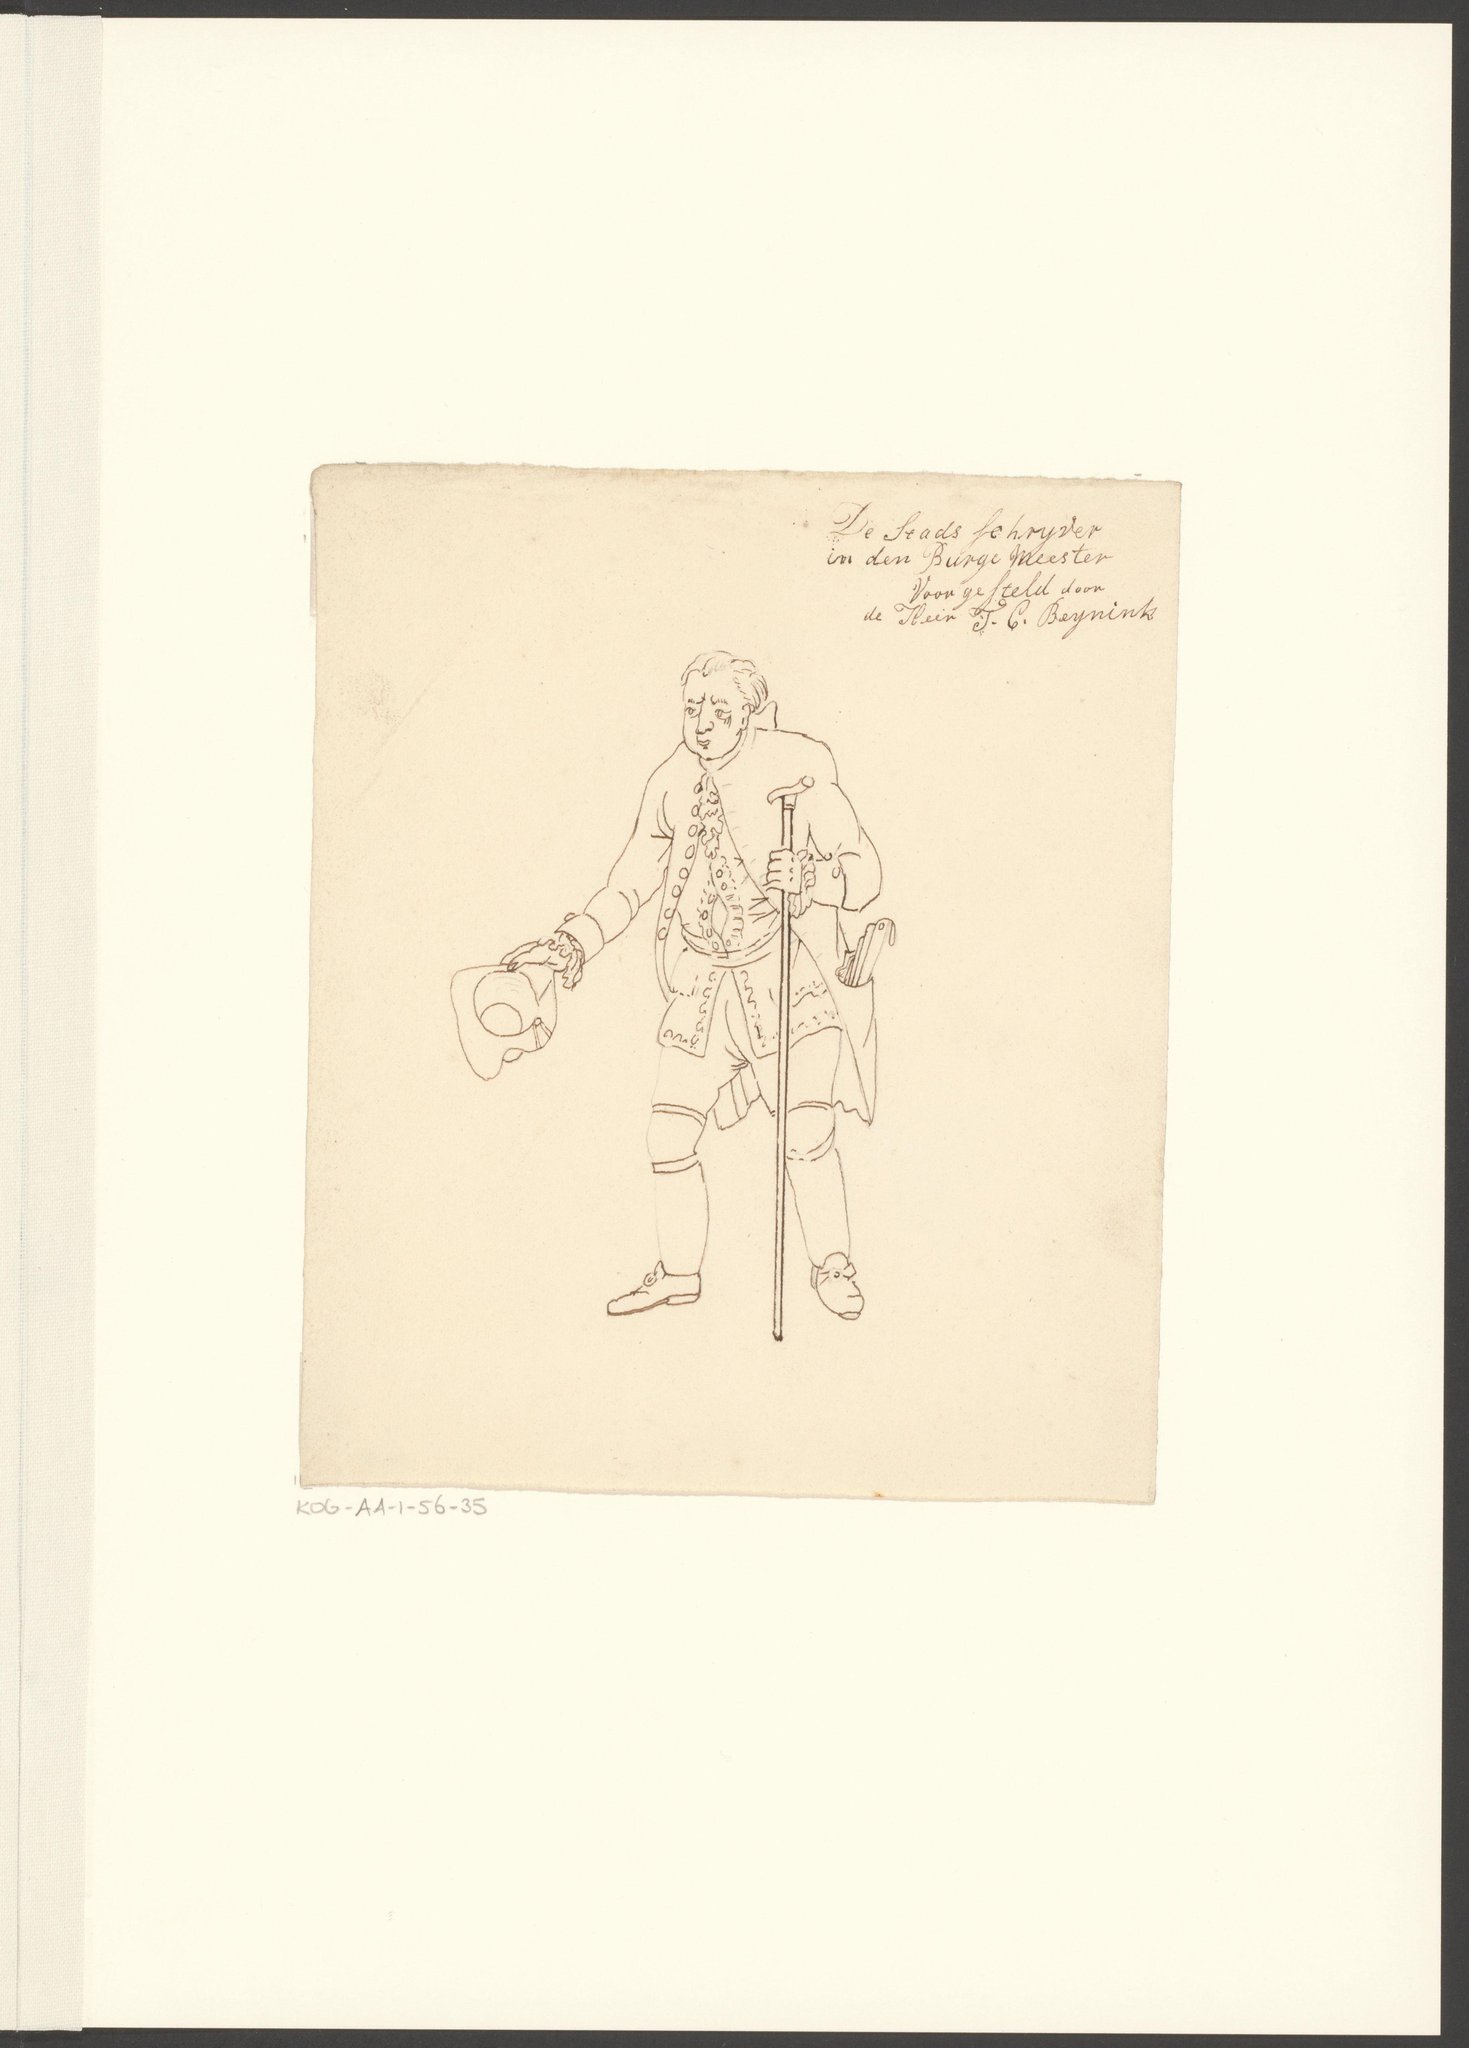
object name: drawing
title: Portret van toneelspeler Theunis Christoffel Beynink in de rol van stadsschrijver en burgemeester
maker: johannes jelgerhuis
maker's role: draughtsman, painter, print maker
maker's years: 1770-1836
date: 1786-1832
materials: ink, paper, pencil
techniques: pen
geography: amsterdam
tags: teunis christoffel beynink, historical persons, portrait of actor, actress, actor (on the stage), amsterdam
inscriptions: inscription: ‘De stads schryver / in den Burge Meester / Voorgesteld door / de Heer T.C. Beynink’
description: Voorbereidende tekening op de prentserie Acteurs en actrices in verschillende rollen van Johannes Jelgerhuis.